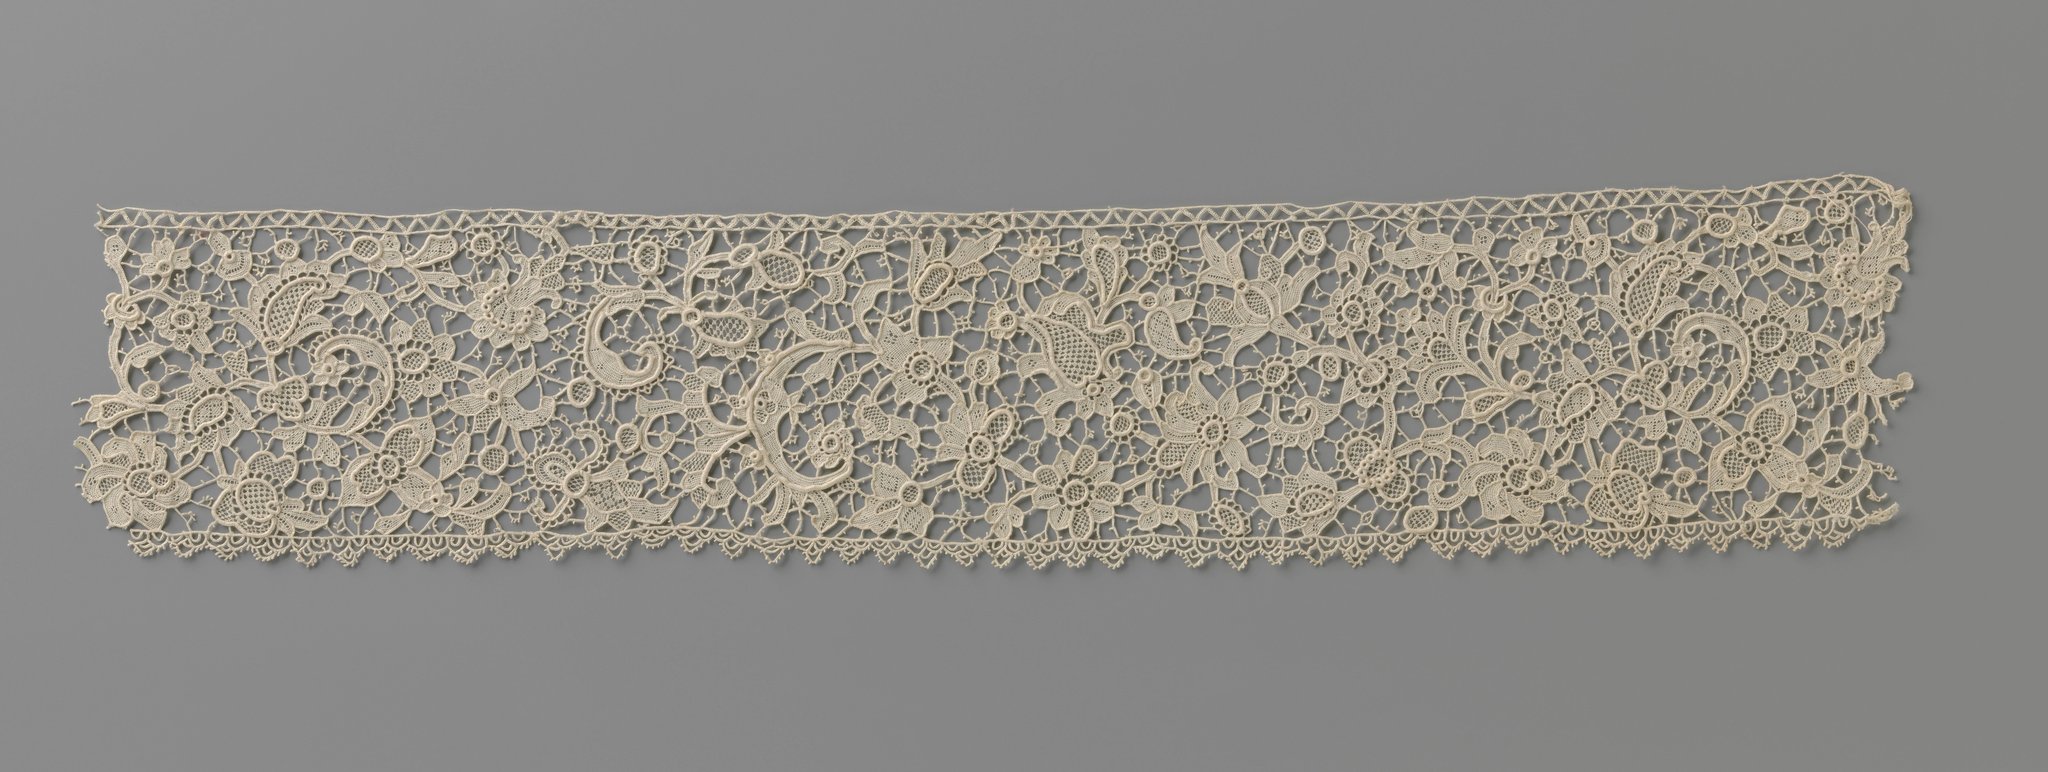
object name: strip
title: Strook naaldkant met veermotief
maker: Anonymous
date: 1875-1909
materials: linen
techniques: embroidery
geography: burano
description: Strook naturelkleurige naaldkant: Venetiaanse reliëfkant. Op een open spijlengrond staan ranken met veelsoortige bloemen, waaronder bloemen met een veermotief. Het betreft een doorlopend patroon met rapport. De bovenrand is recht afgewerkt met gelijke driehoekjes. De onderrand is afgewerkt met boogjes en picots.